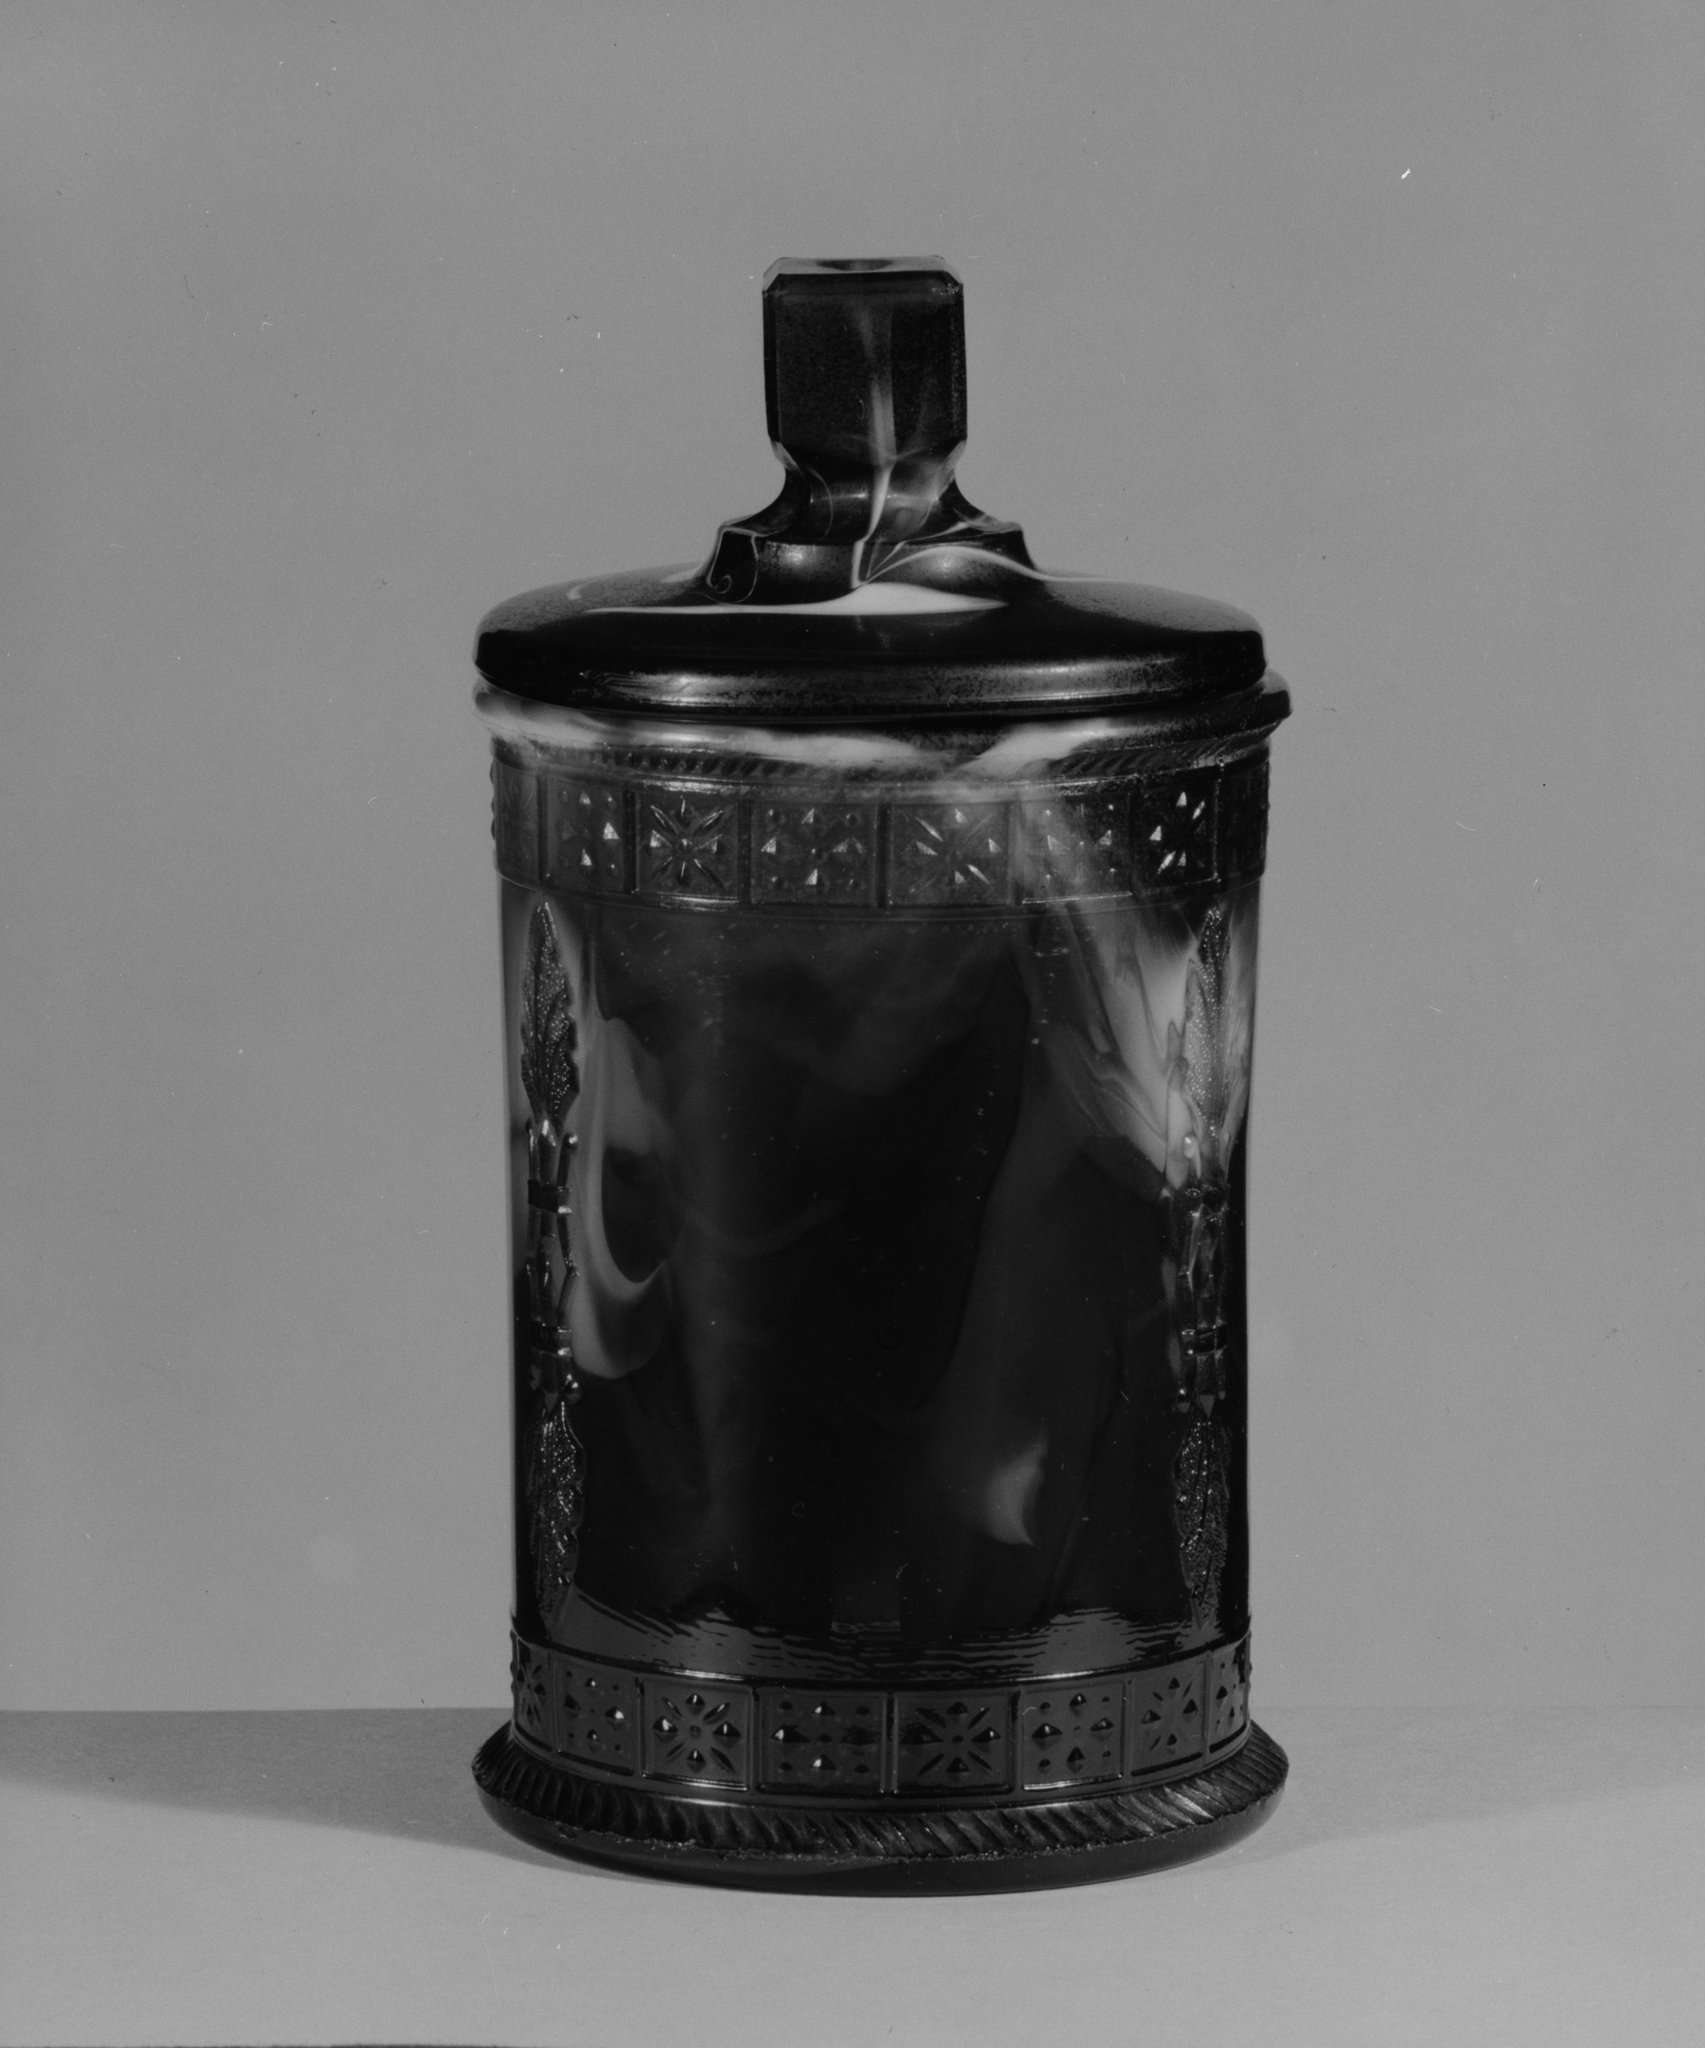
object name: marmalade jar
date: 1870-1880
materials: glass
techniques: pressed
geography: england